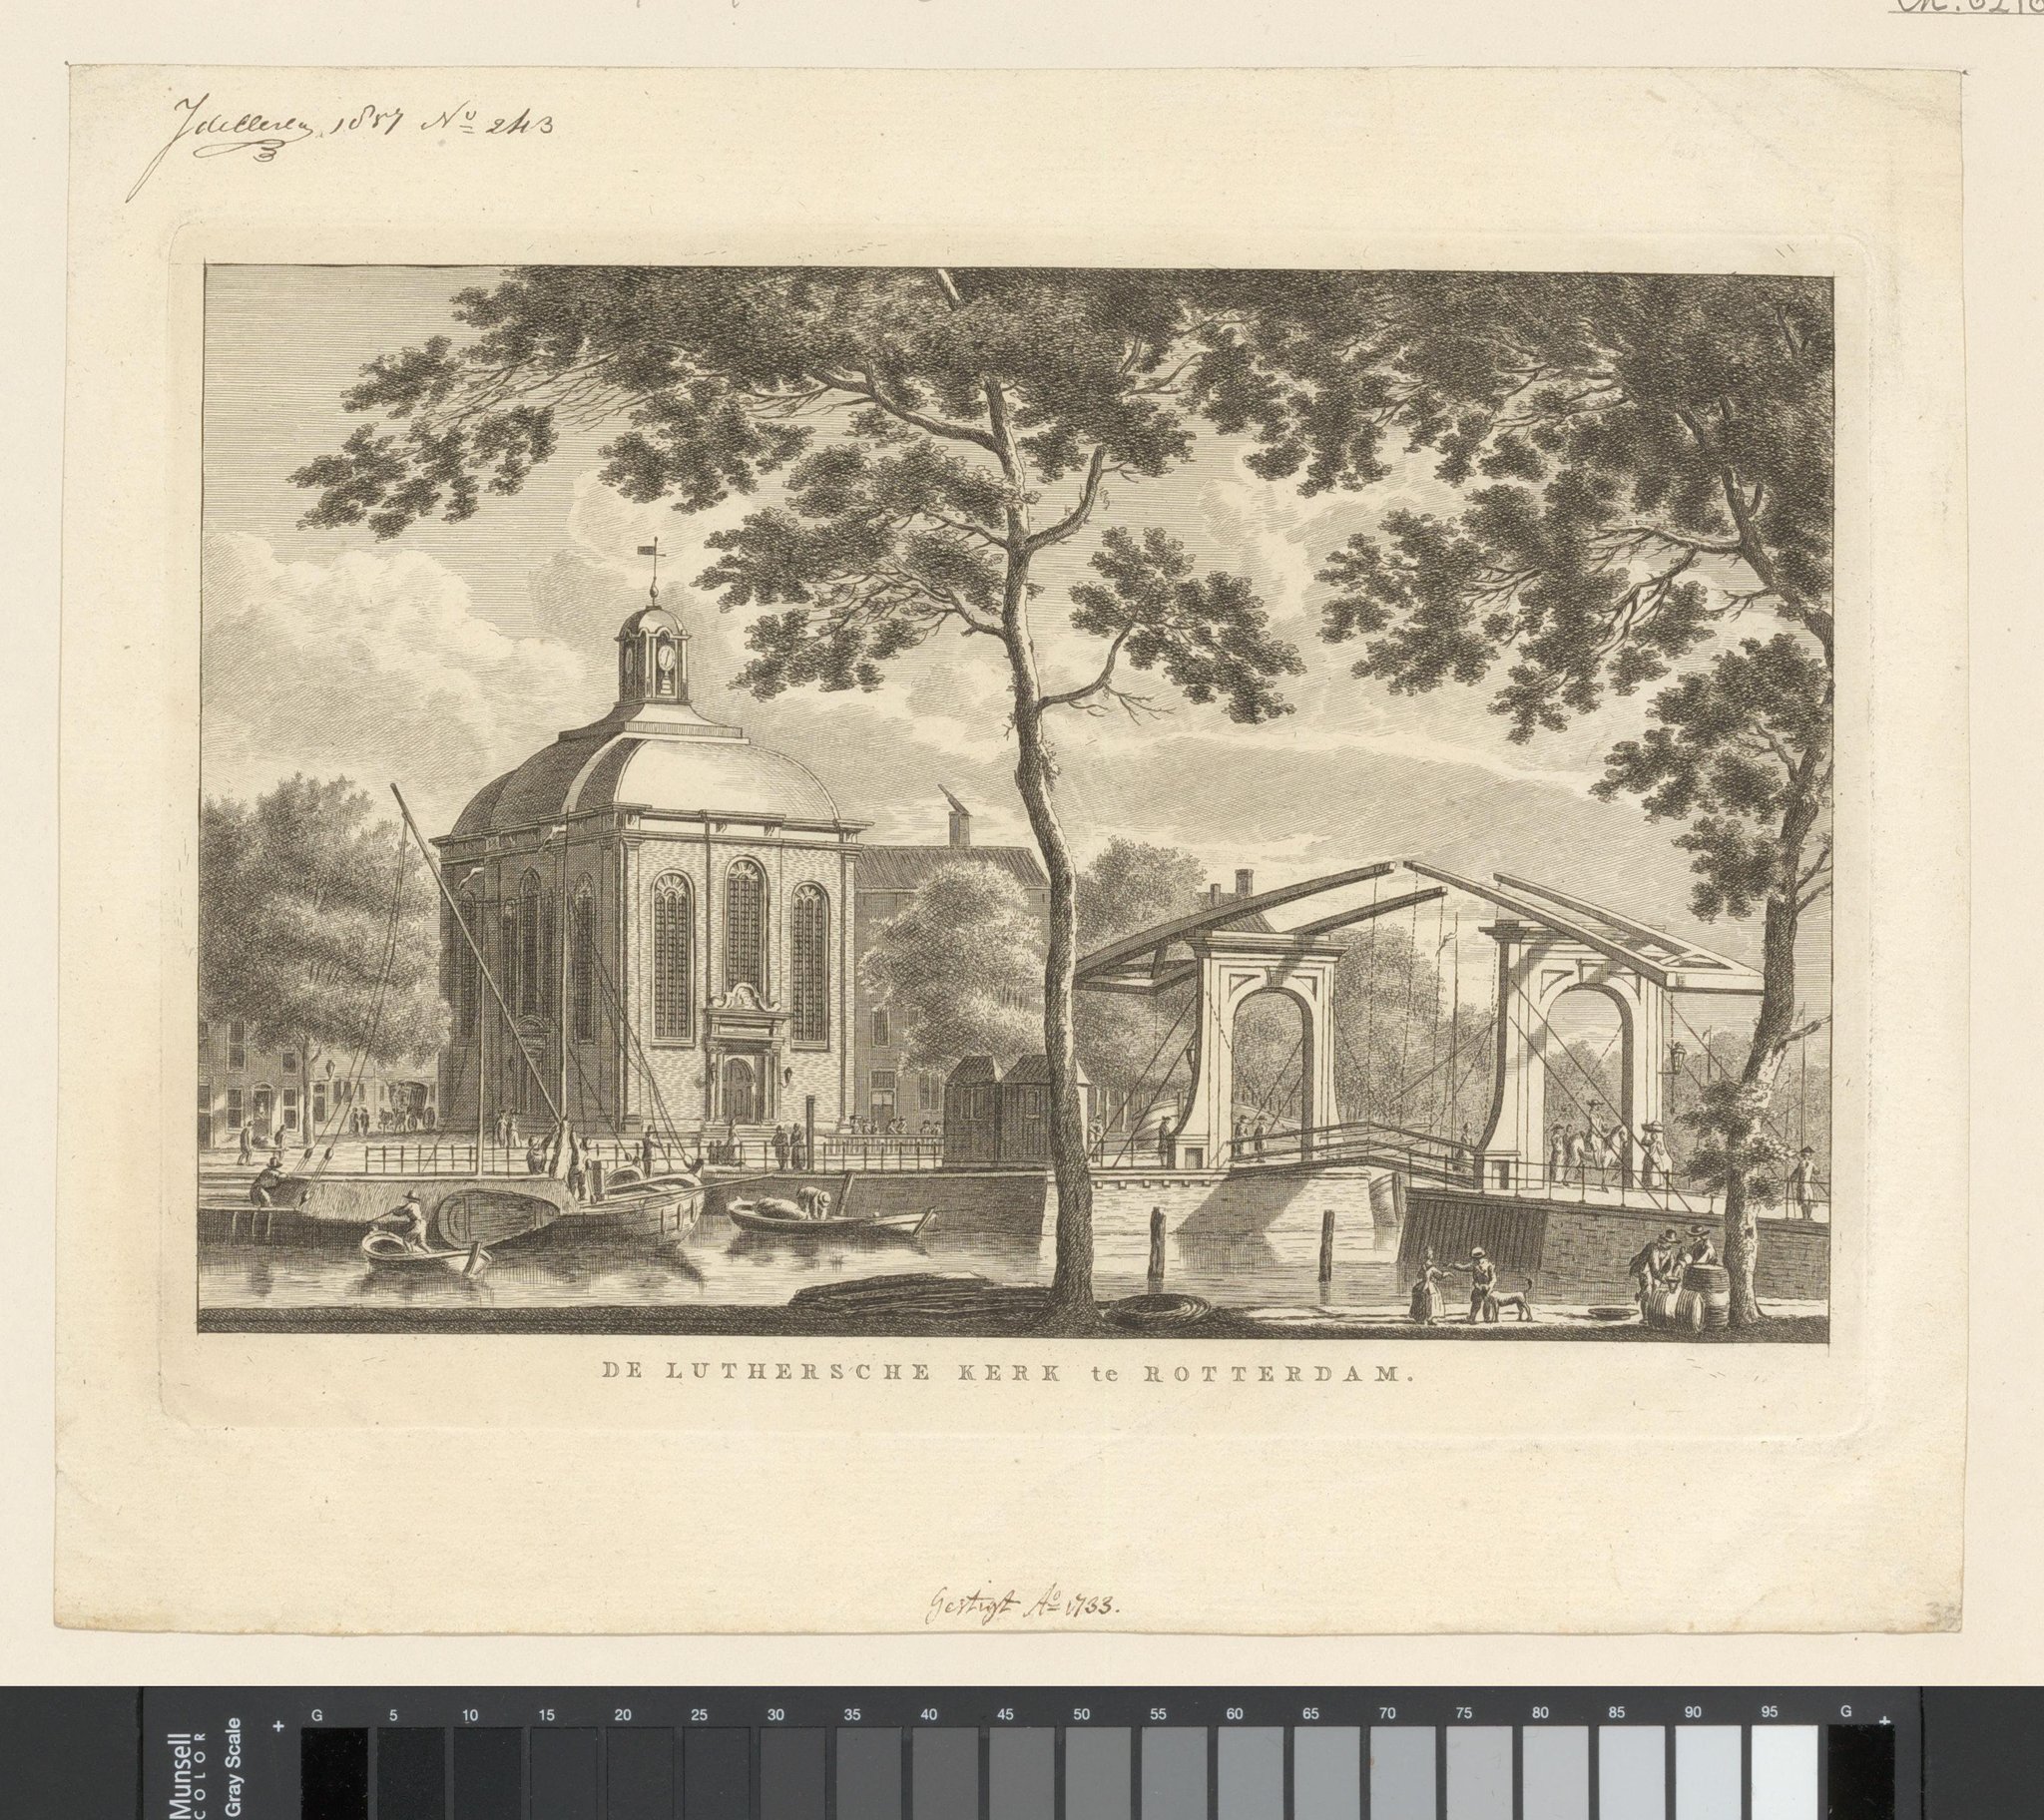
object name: print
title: De Luthersche kerk te Rotterdam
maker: carel frederik bendorp (i)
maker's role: print maker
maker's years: 1736-1814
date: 1786-1792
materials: paper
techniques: engraving, etching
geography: amersfoort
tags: church (exterior), bridge in city across river, canal, etc.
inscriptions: inscription: ‘JdeClercq 1857 No. 243’, collector's mark, collector's mark: Lugt 1641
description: Prent uit: Vaderlandsche gezichten, of afbeeldingen van den tegenwoordigen staat der Vereenigde Nederlanden (…). Amsterdam: Hendrik Gartman, Willem Vermandel en Jan Willem Smit, 1786-1792. Uitgegeven in afleveringen met ieder een eigen bifolium en inhoudsopgave. Alle prenten in deze publicatie zijn gegraveerd door Carel Frederik Bendorp (I) en, in de meeste gevallen, gebaseerd op tekeningen van Jan Bulthuis.